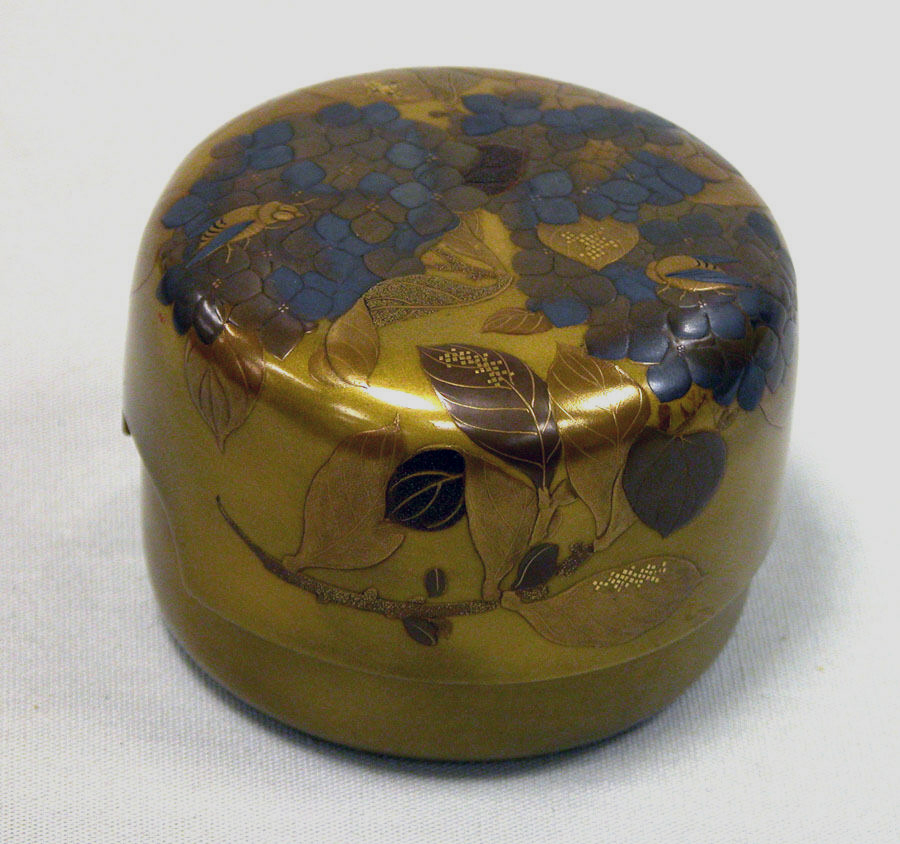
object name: incense box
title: Incense box with hydrangea and bee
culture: japanese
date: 1851-1900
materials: gold, gold foil, gold leaf, silver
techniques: cutting, hiramakie, maki-e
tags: bees,leaves